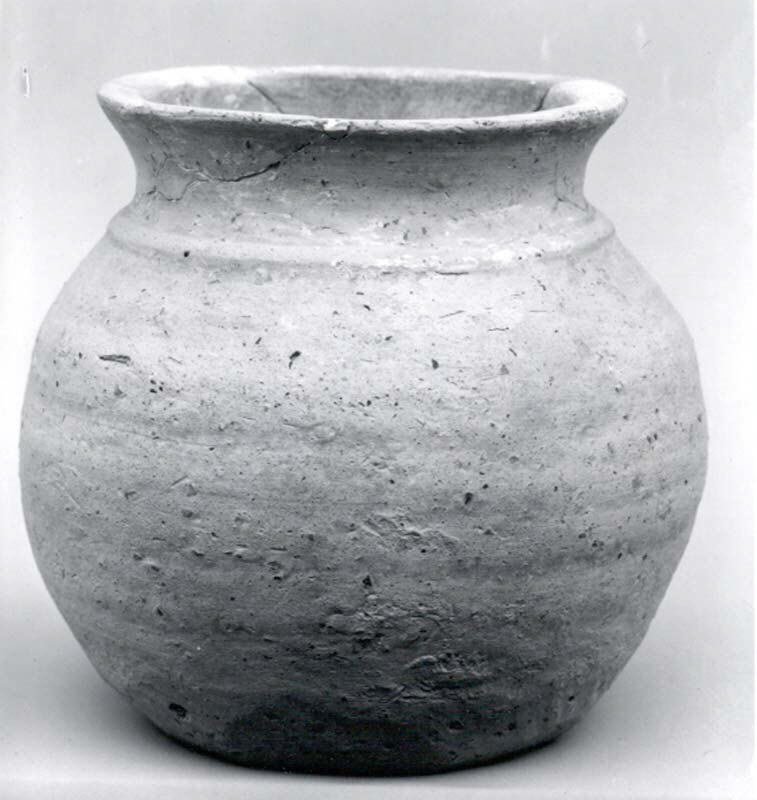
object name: jar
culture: sasanian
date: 201-700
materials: ceramic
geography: iran